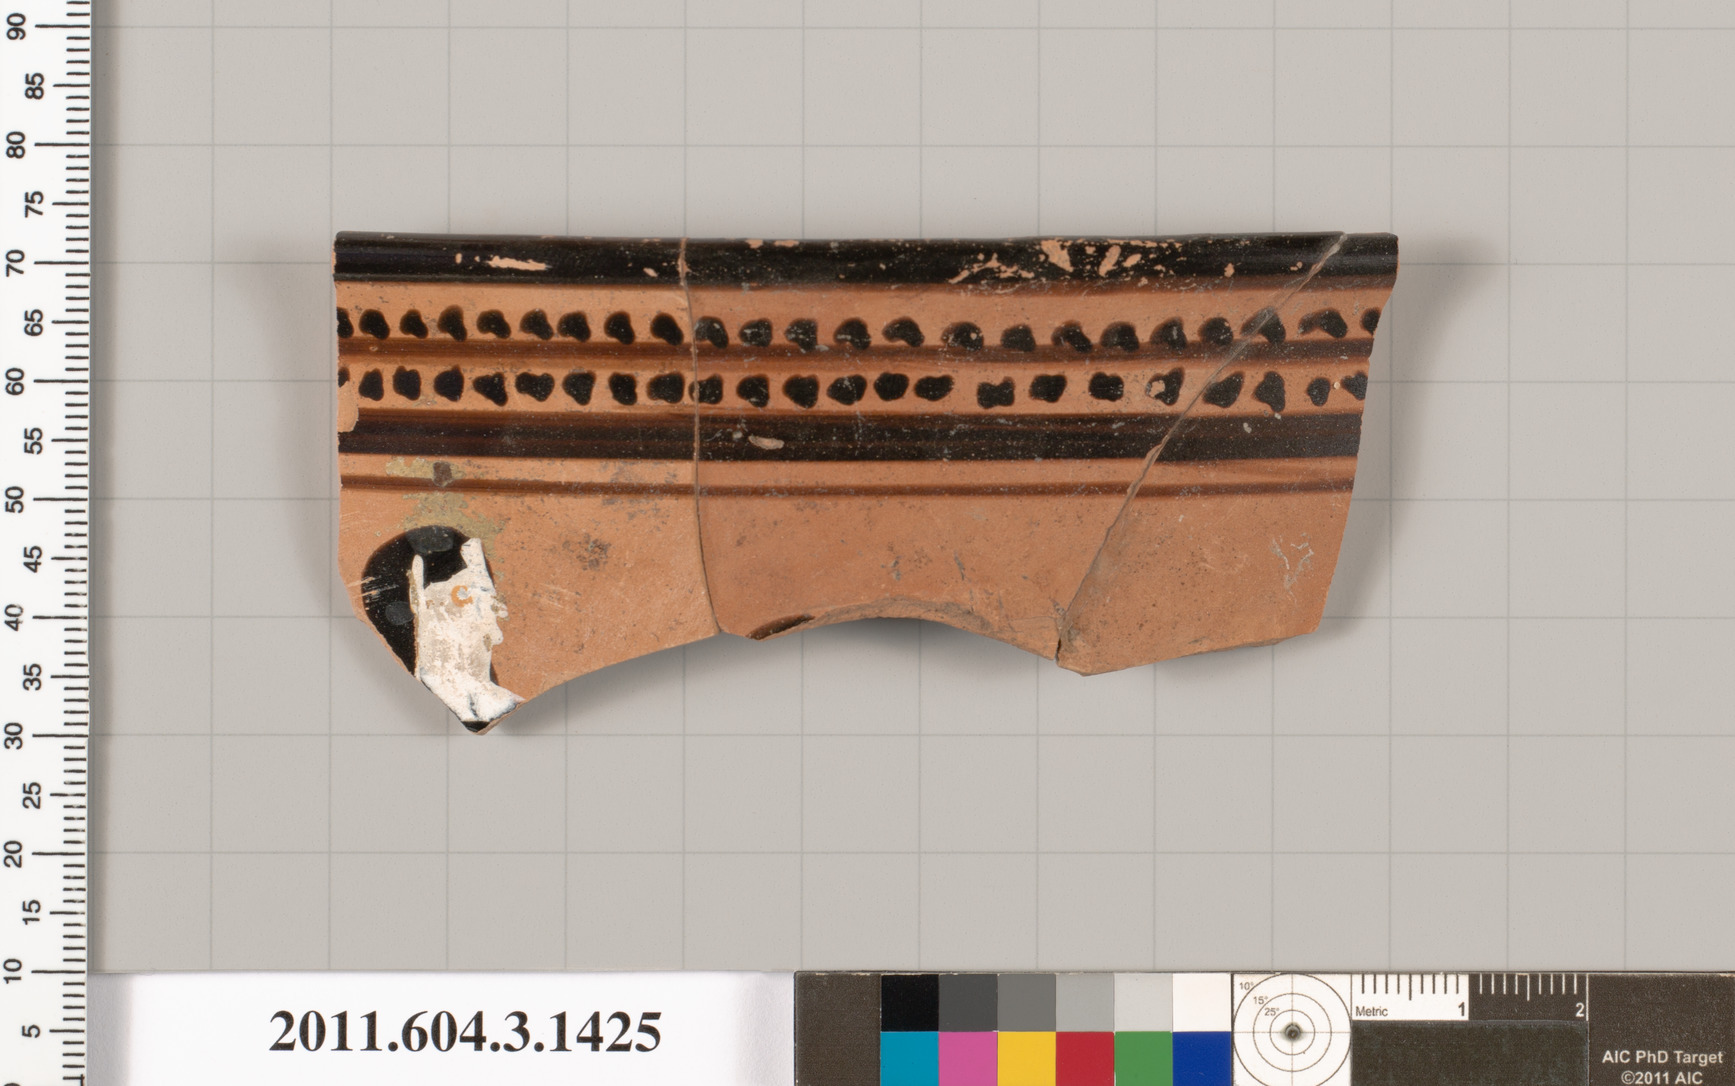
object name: skyphos fragment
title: Terracotta rim fragment of a skyphos (deep drinking cup)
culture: greek, attic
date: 500-468 BCE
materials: terracotta